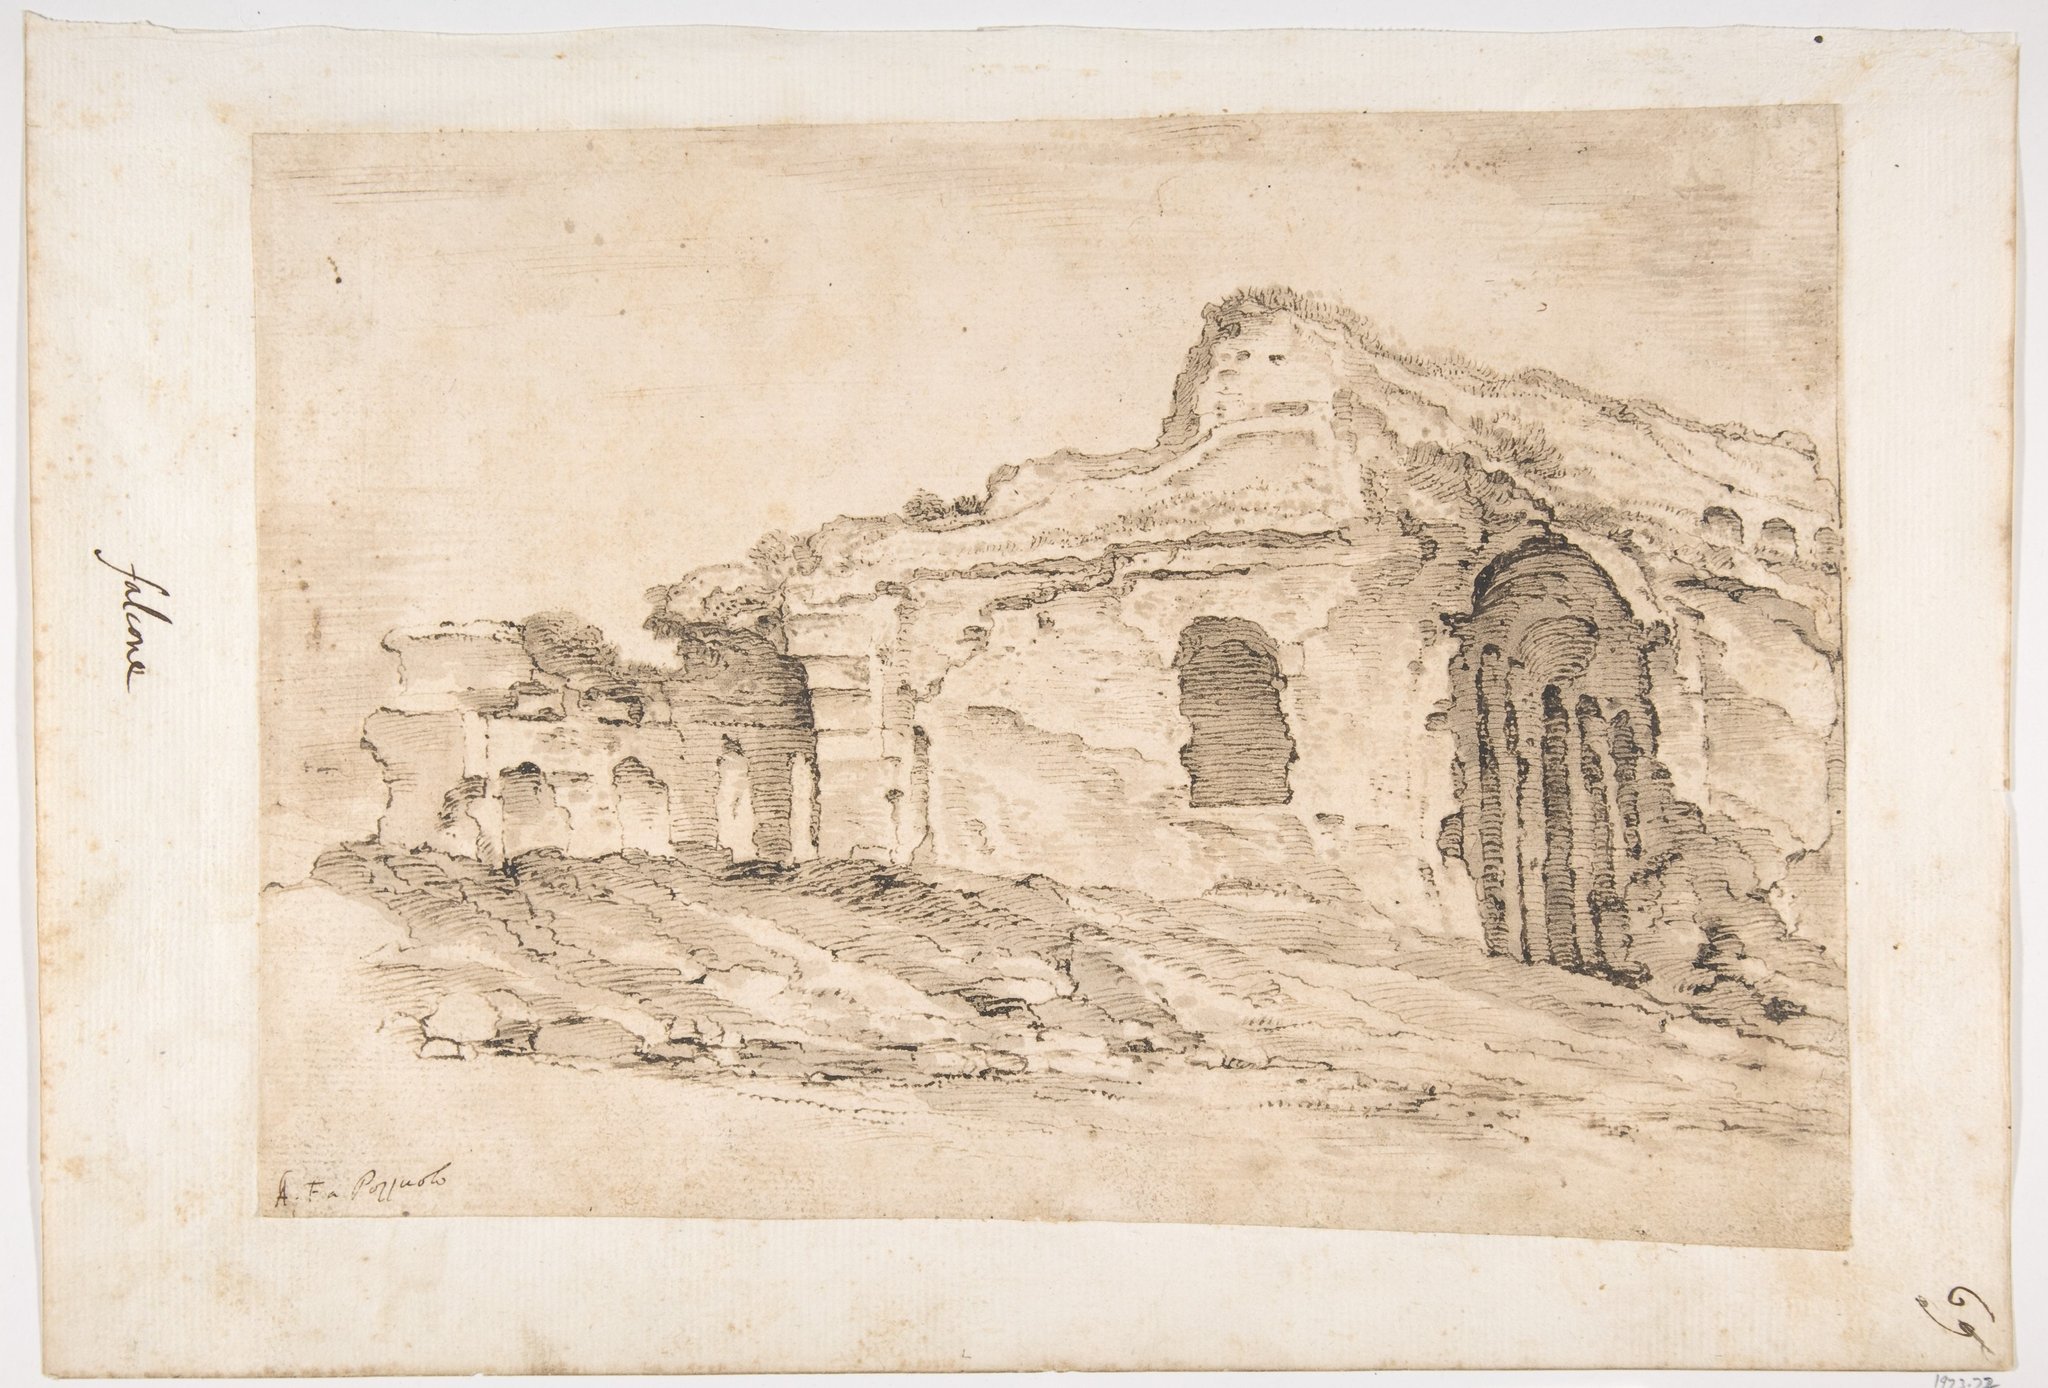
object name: drawing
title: Ruins of the Roman Arena at Pozzuoli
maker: aniello falcone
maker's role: artist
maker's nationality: italian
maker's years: 1607-1656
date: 1607-1656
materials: ink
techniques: brush, pen, wash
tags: ruins